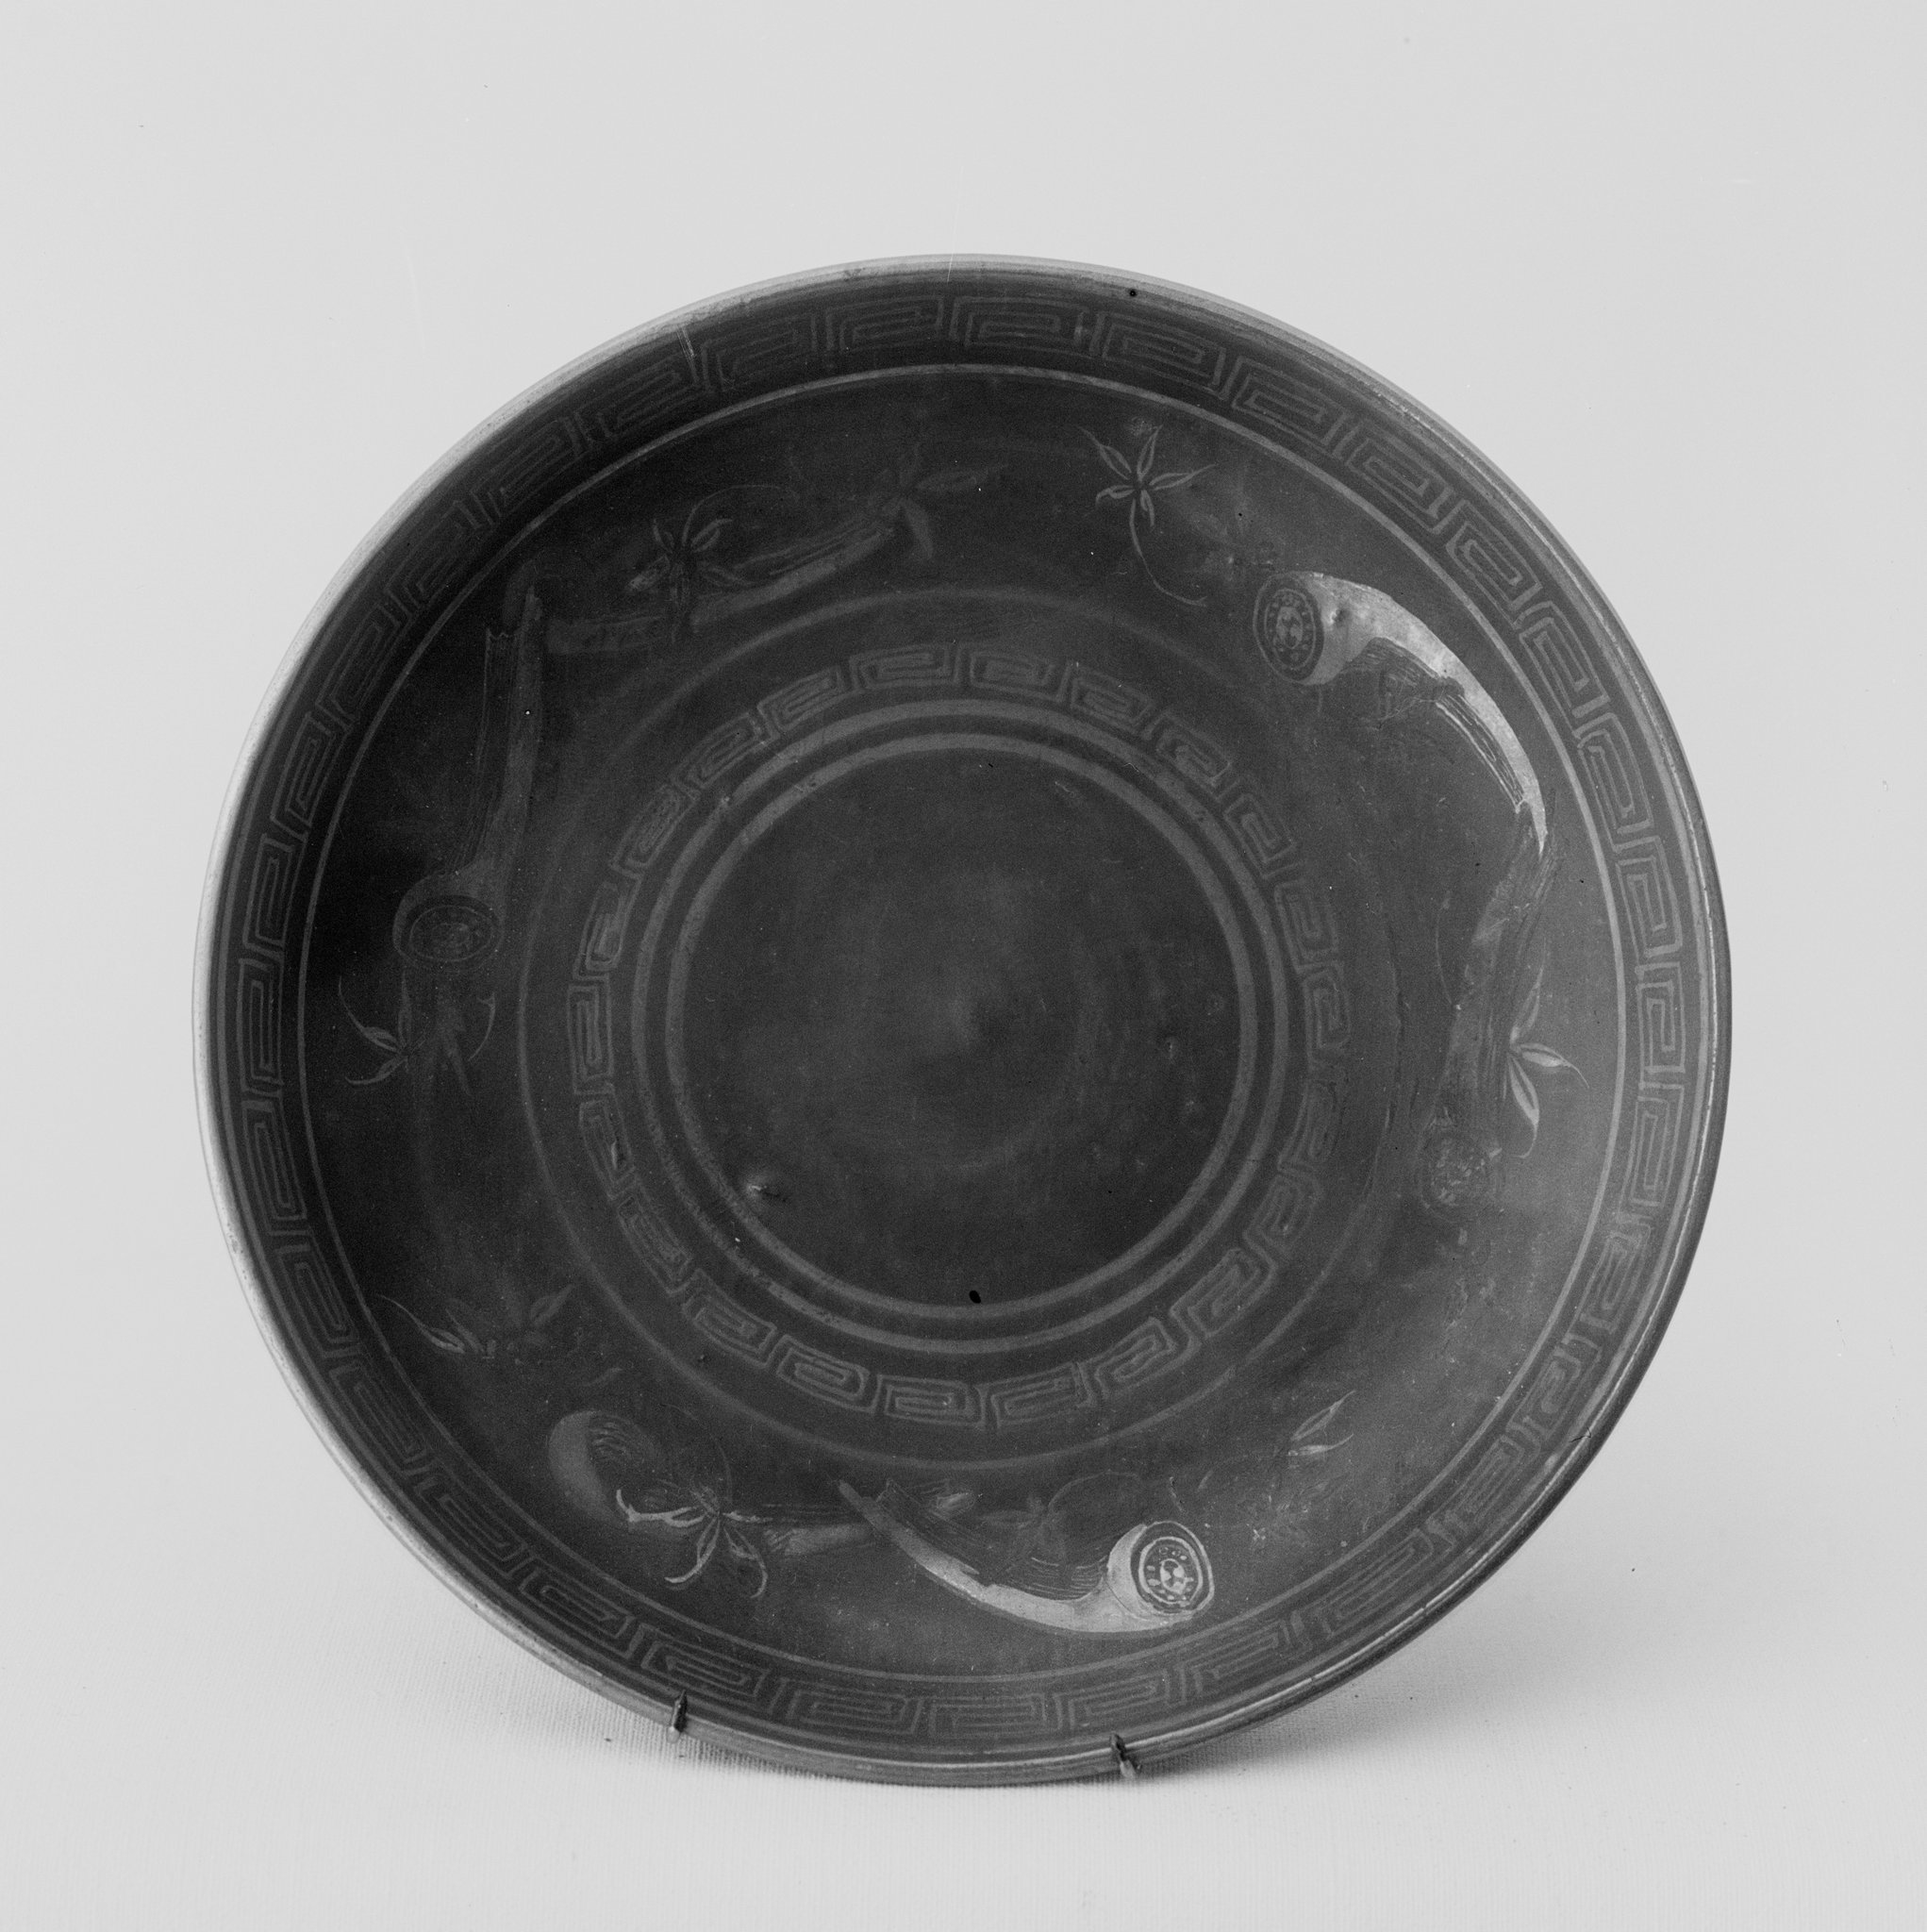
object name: saucer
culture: japanese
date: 1801-1900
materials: gold, porcelain, silver